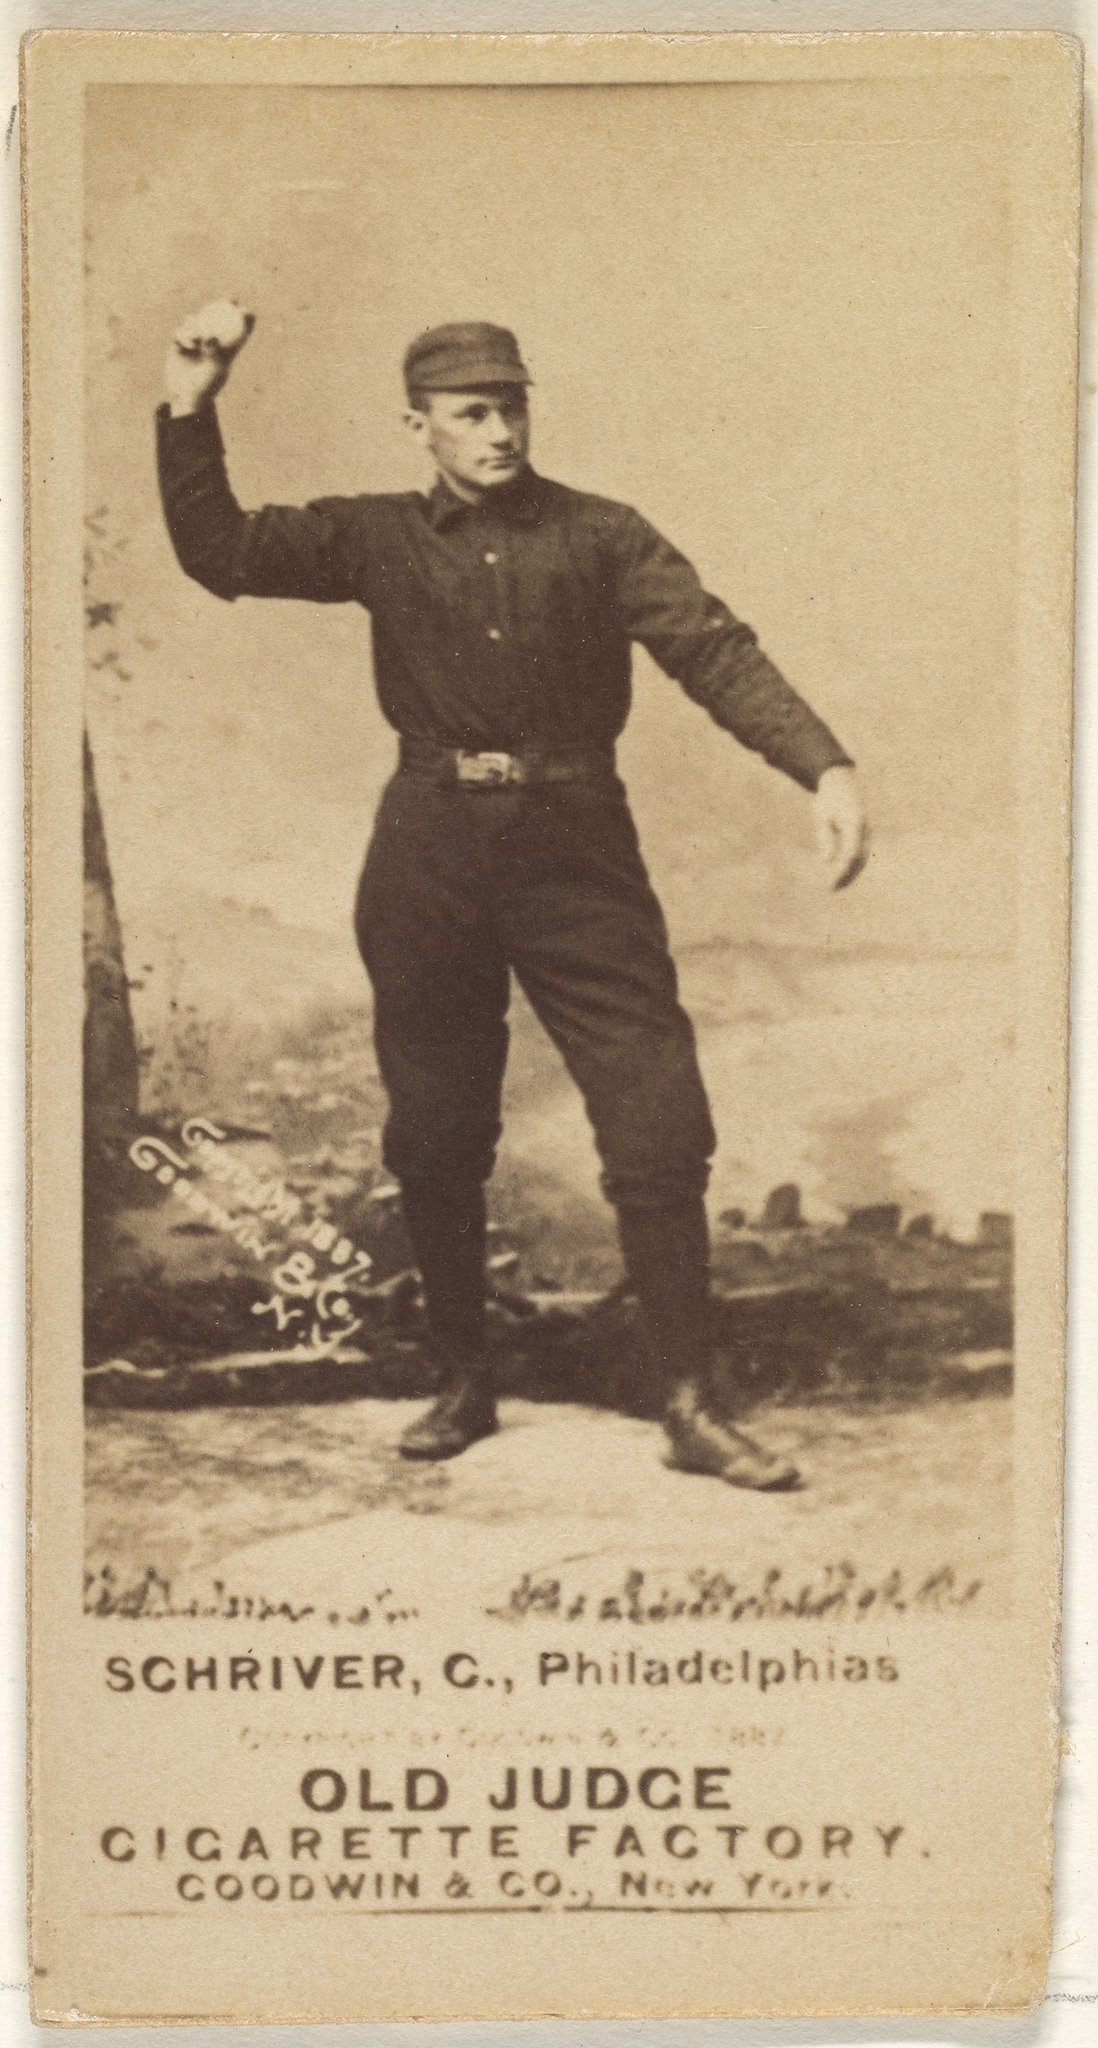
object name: baseball card, photograph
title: William Frederick "Pop" Schriver, Catcher, Philadelphia, from the Old Judge series (N172) for Old Judge Cigarettes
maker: goodwin & company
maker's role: publisher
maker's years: 1850-1950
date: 1887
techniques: albumen silver print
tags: men,portraits,baseball,athletes